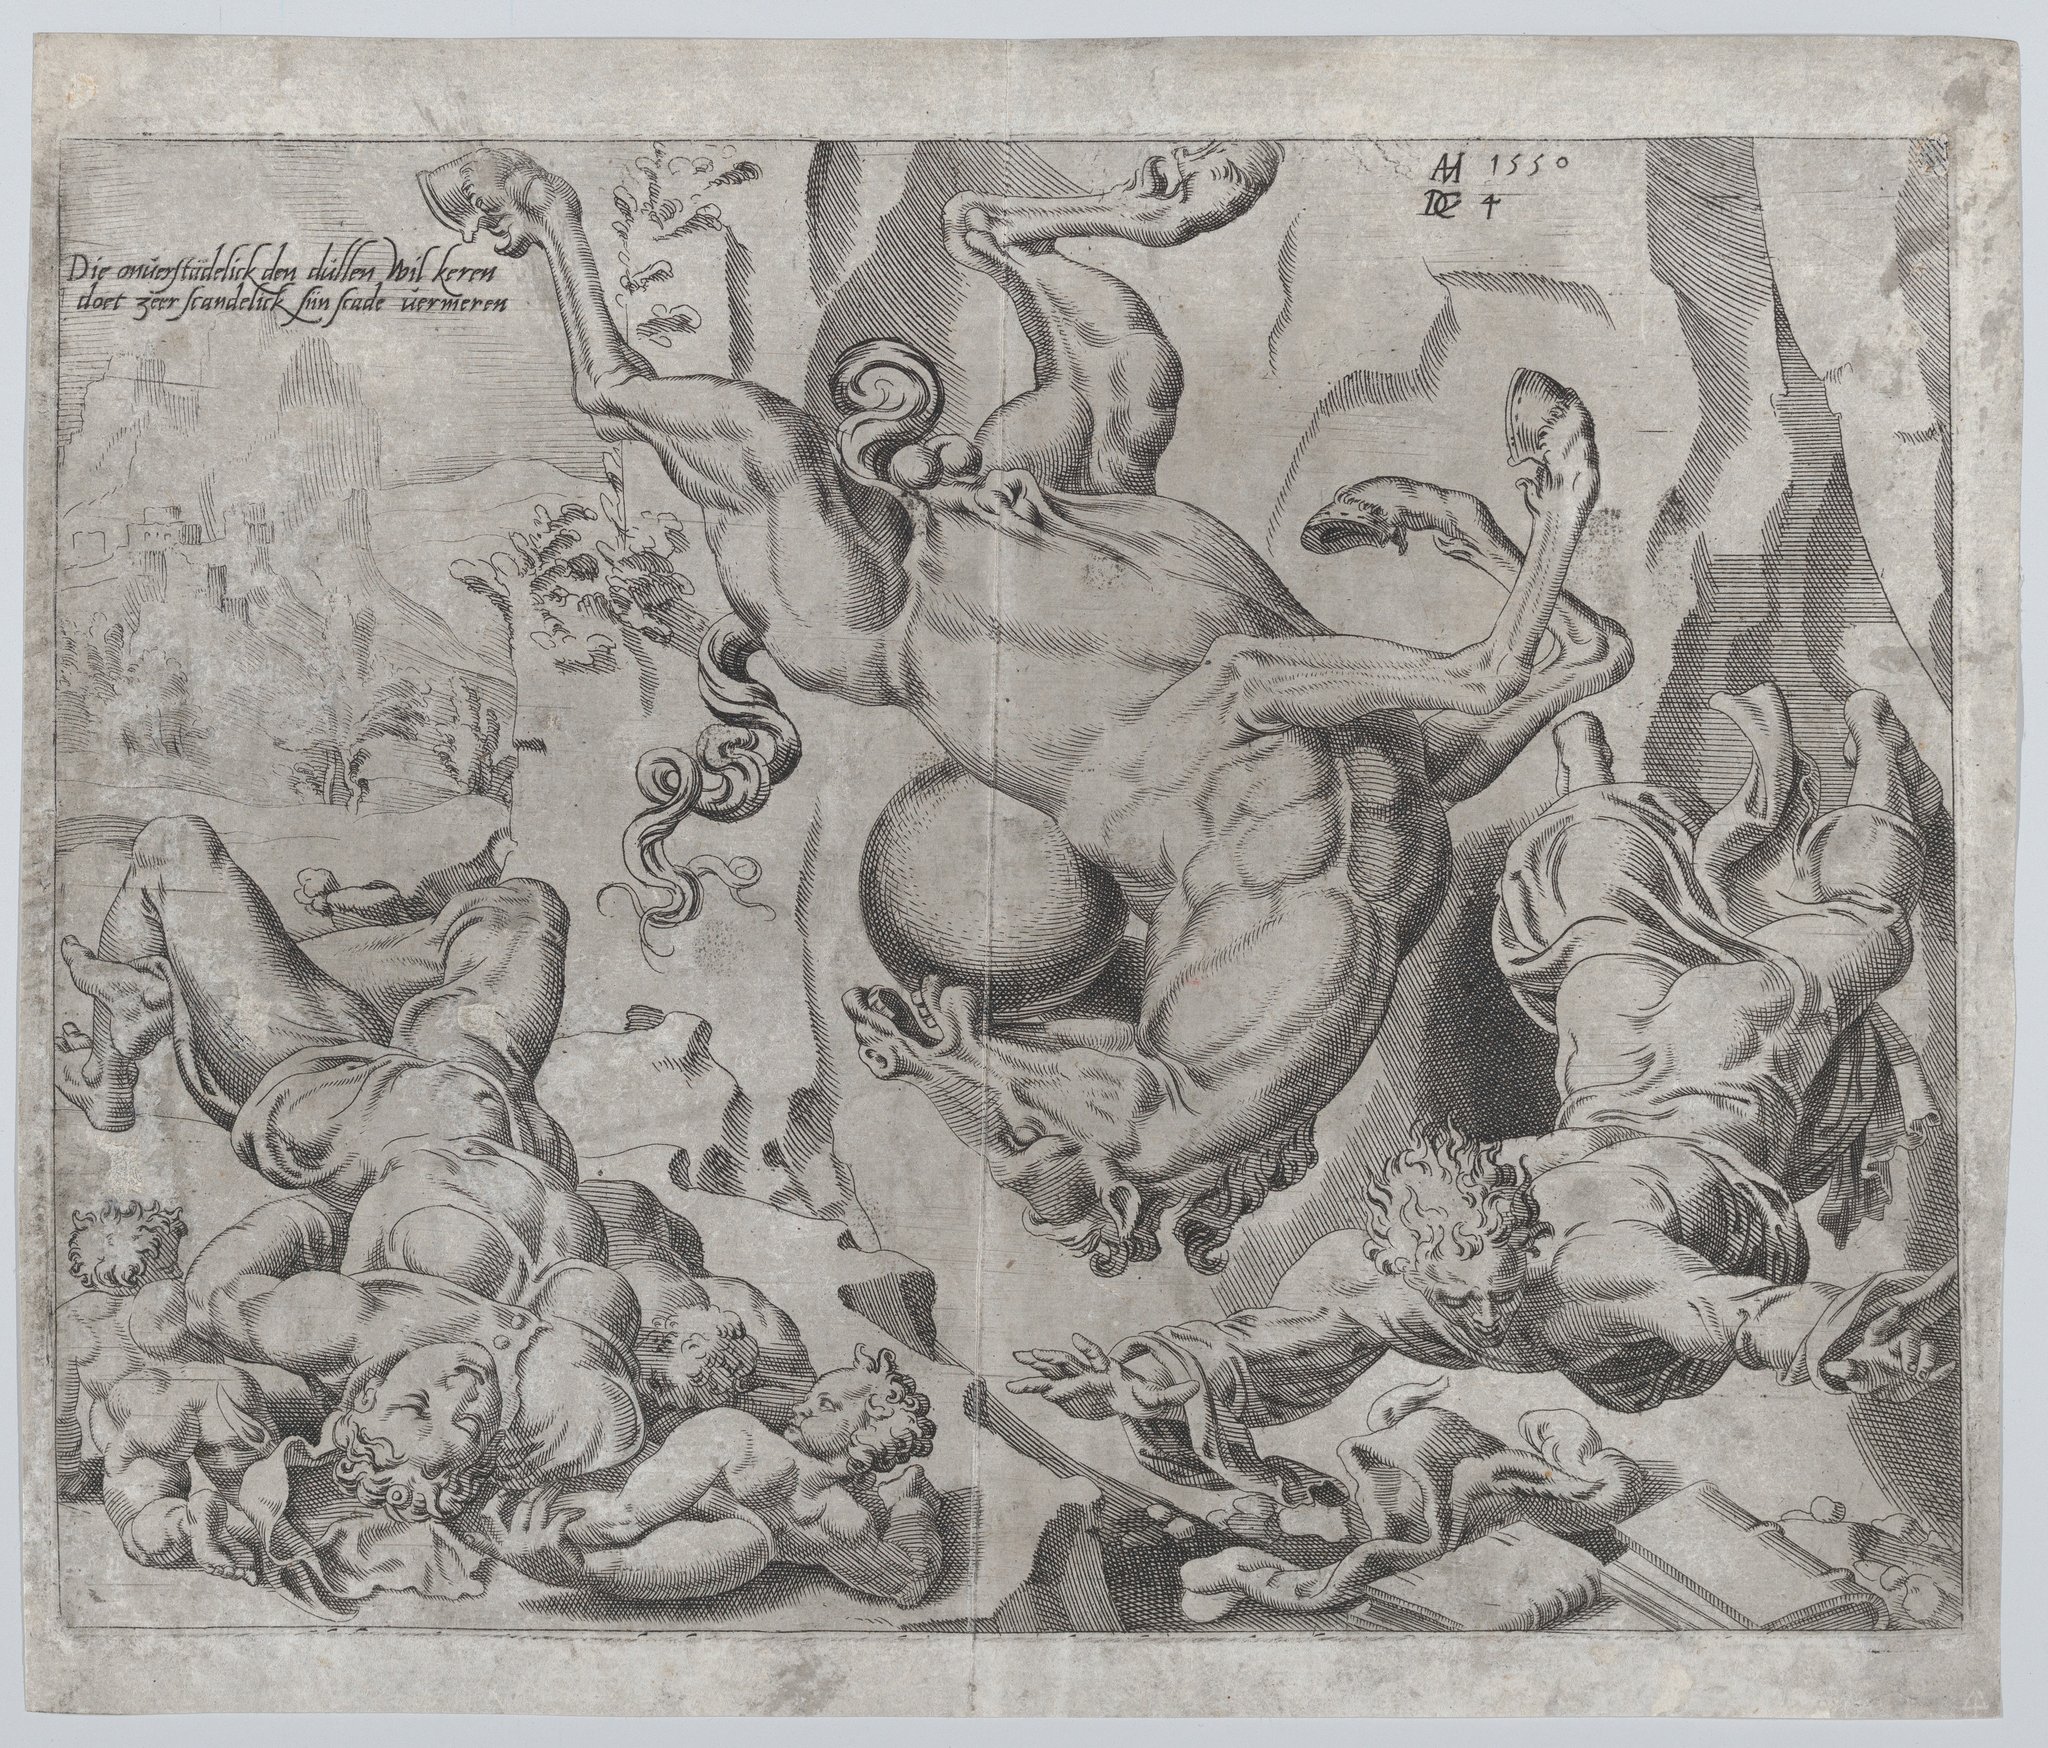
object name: print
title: The World Perishing Together with Knowledge and Love, from The Unrestrained World, plate 4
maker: dirck volckertsz coornhert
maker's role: artist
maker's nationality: netherlandish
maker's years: 1519-1590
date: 1550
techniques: engraving, etching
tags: men,horses